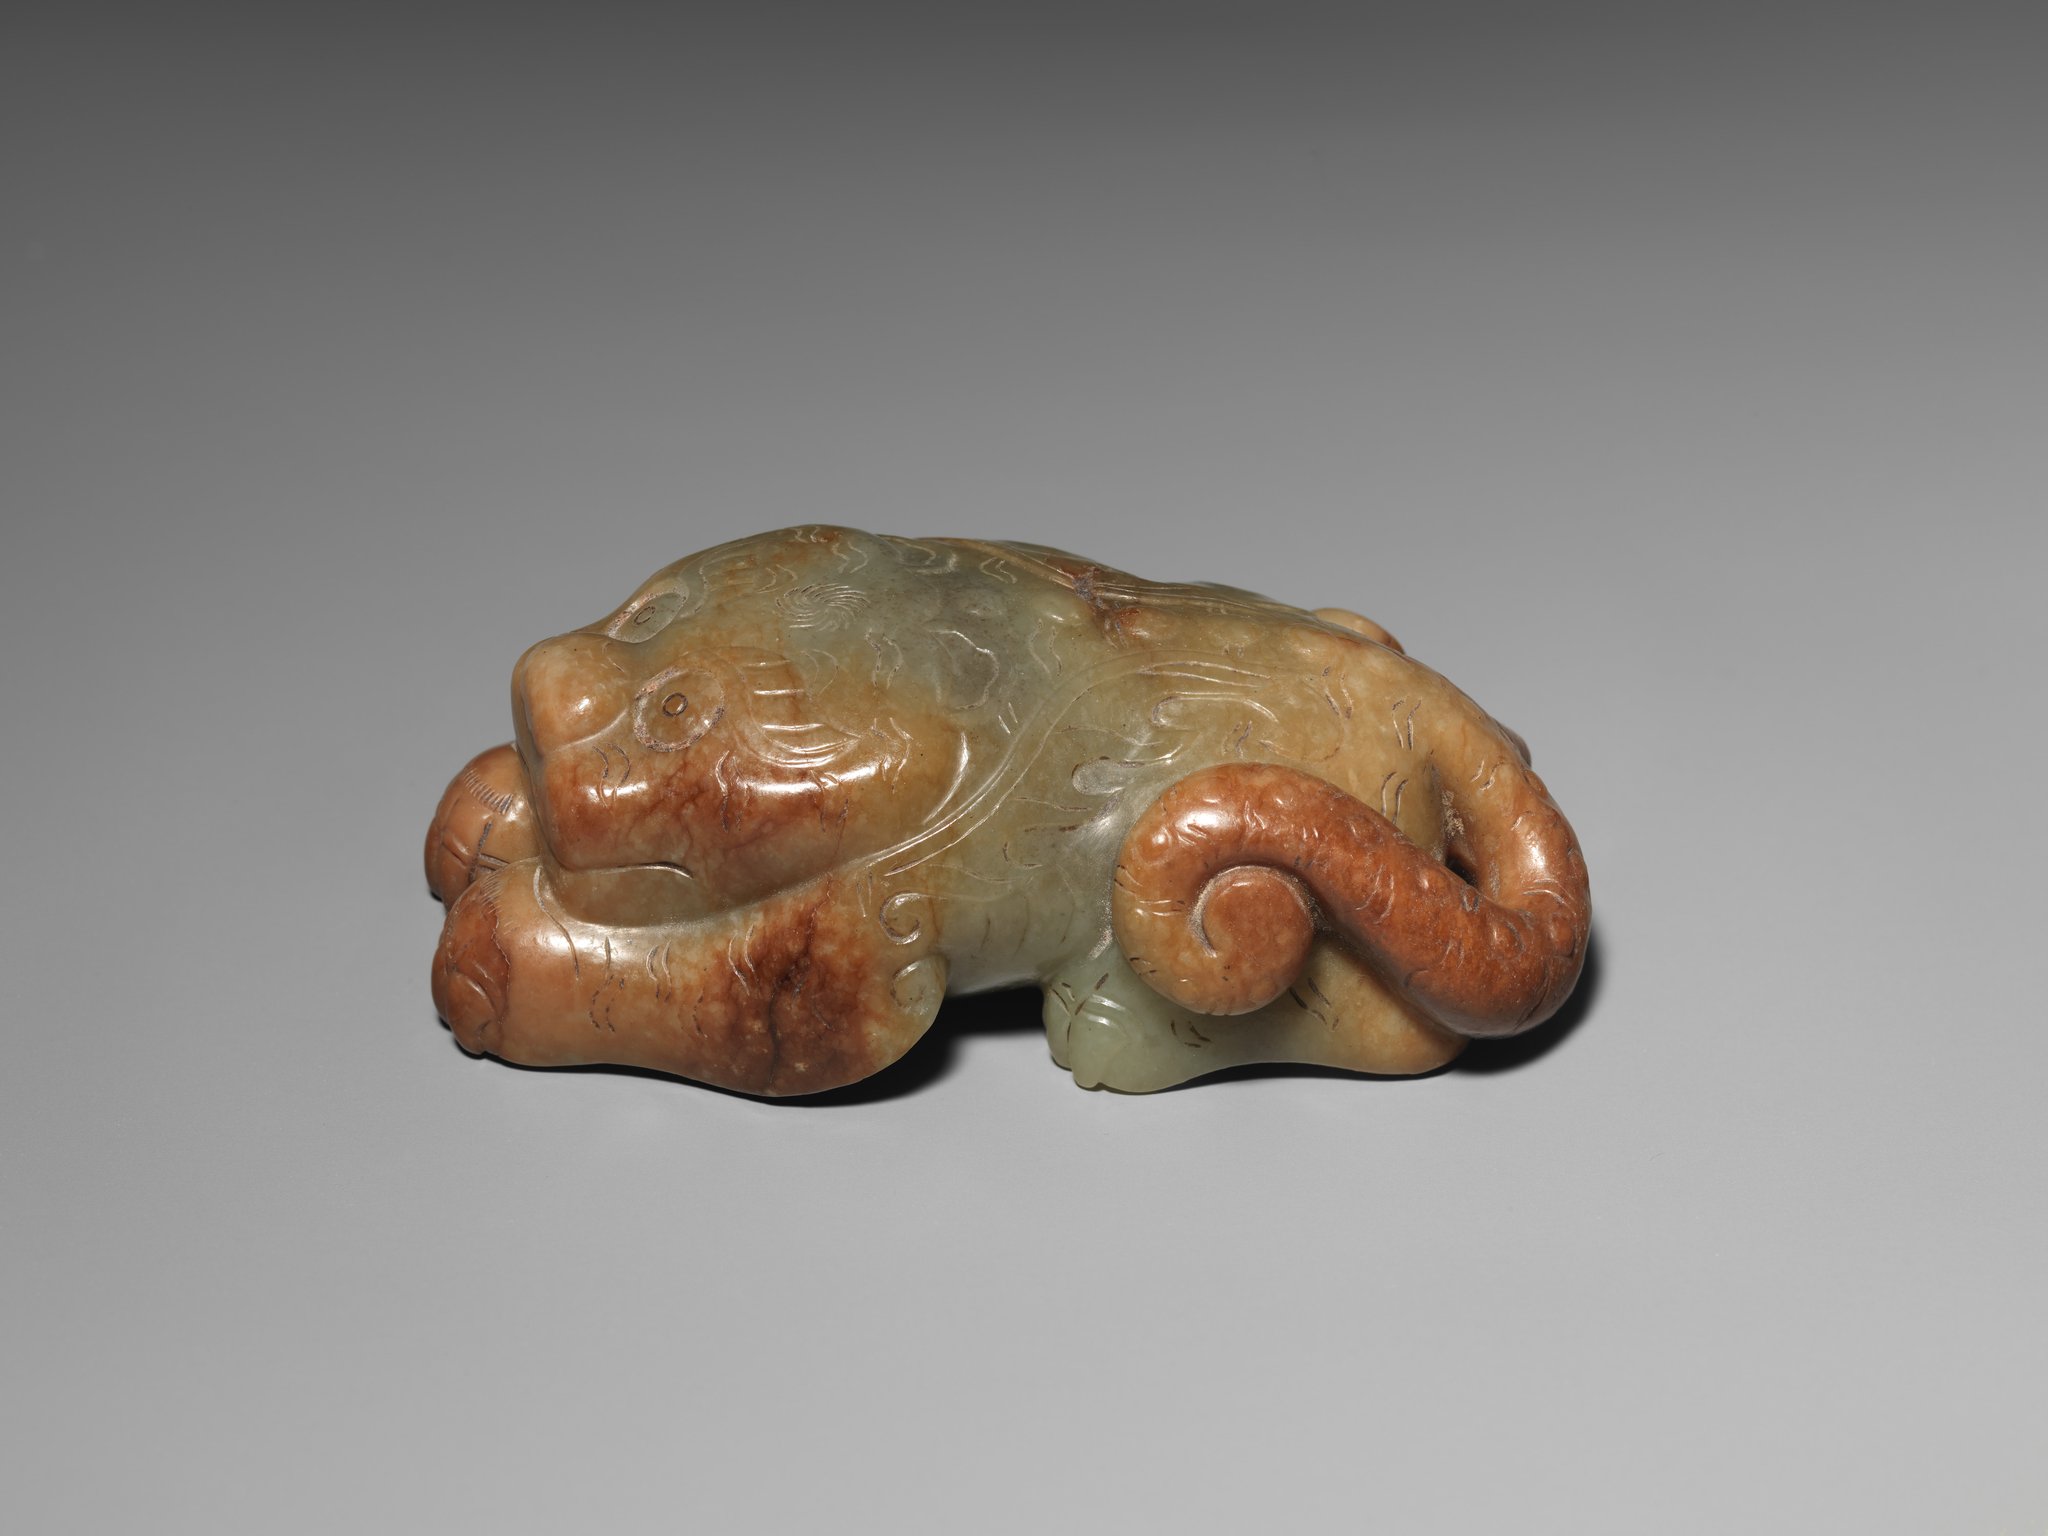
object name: figurine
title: Recumbent Dog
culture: chinese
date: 960-1279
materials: jade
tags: dogs